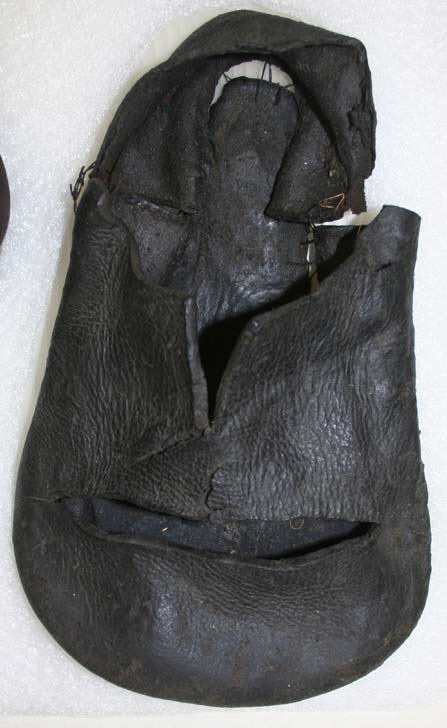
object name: shoe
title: Shoes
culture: british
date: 1501-1600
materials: leather